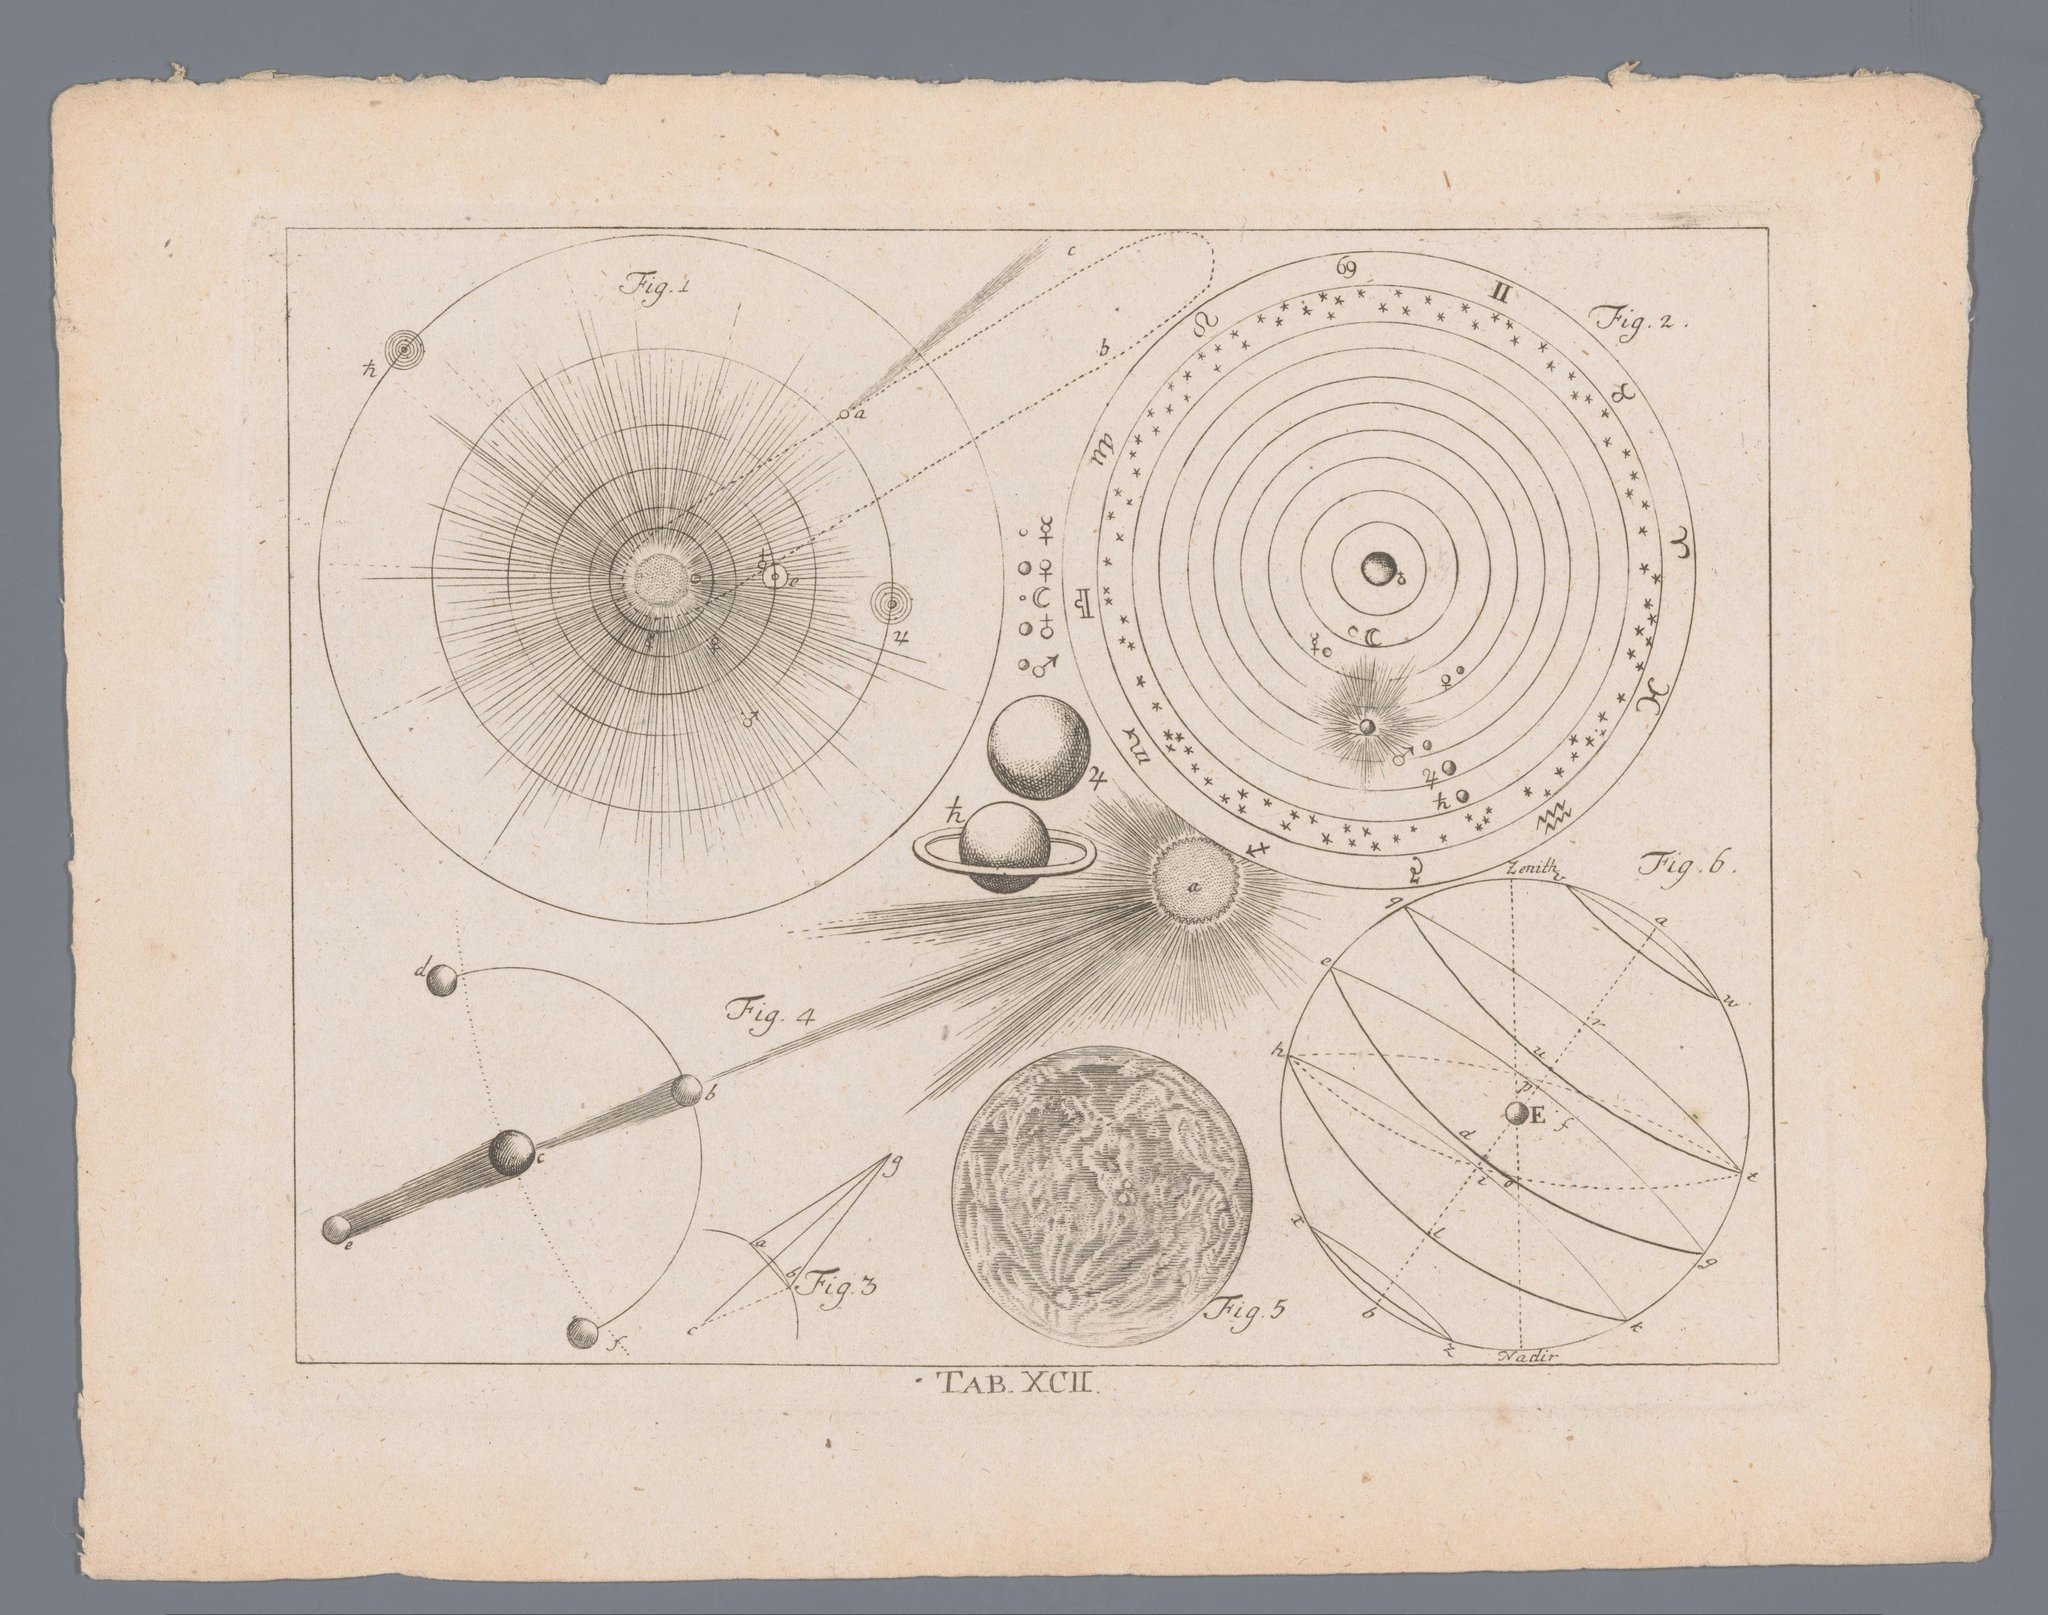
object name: print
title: Zur Physik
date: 1774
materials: paper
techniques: etching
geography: germany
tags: astrology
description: Prent ook gebruikt in: Basedow, Johann Bernhard. Das Basedowische Elementarwerk. Ein Vorrath der besten Erkenntnisse zum Lernen, Lehren, Wiederholen und Nachdenken. Leipzig: Siegfried Lebrecht Crucius, 1774.